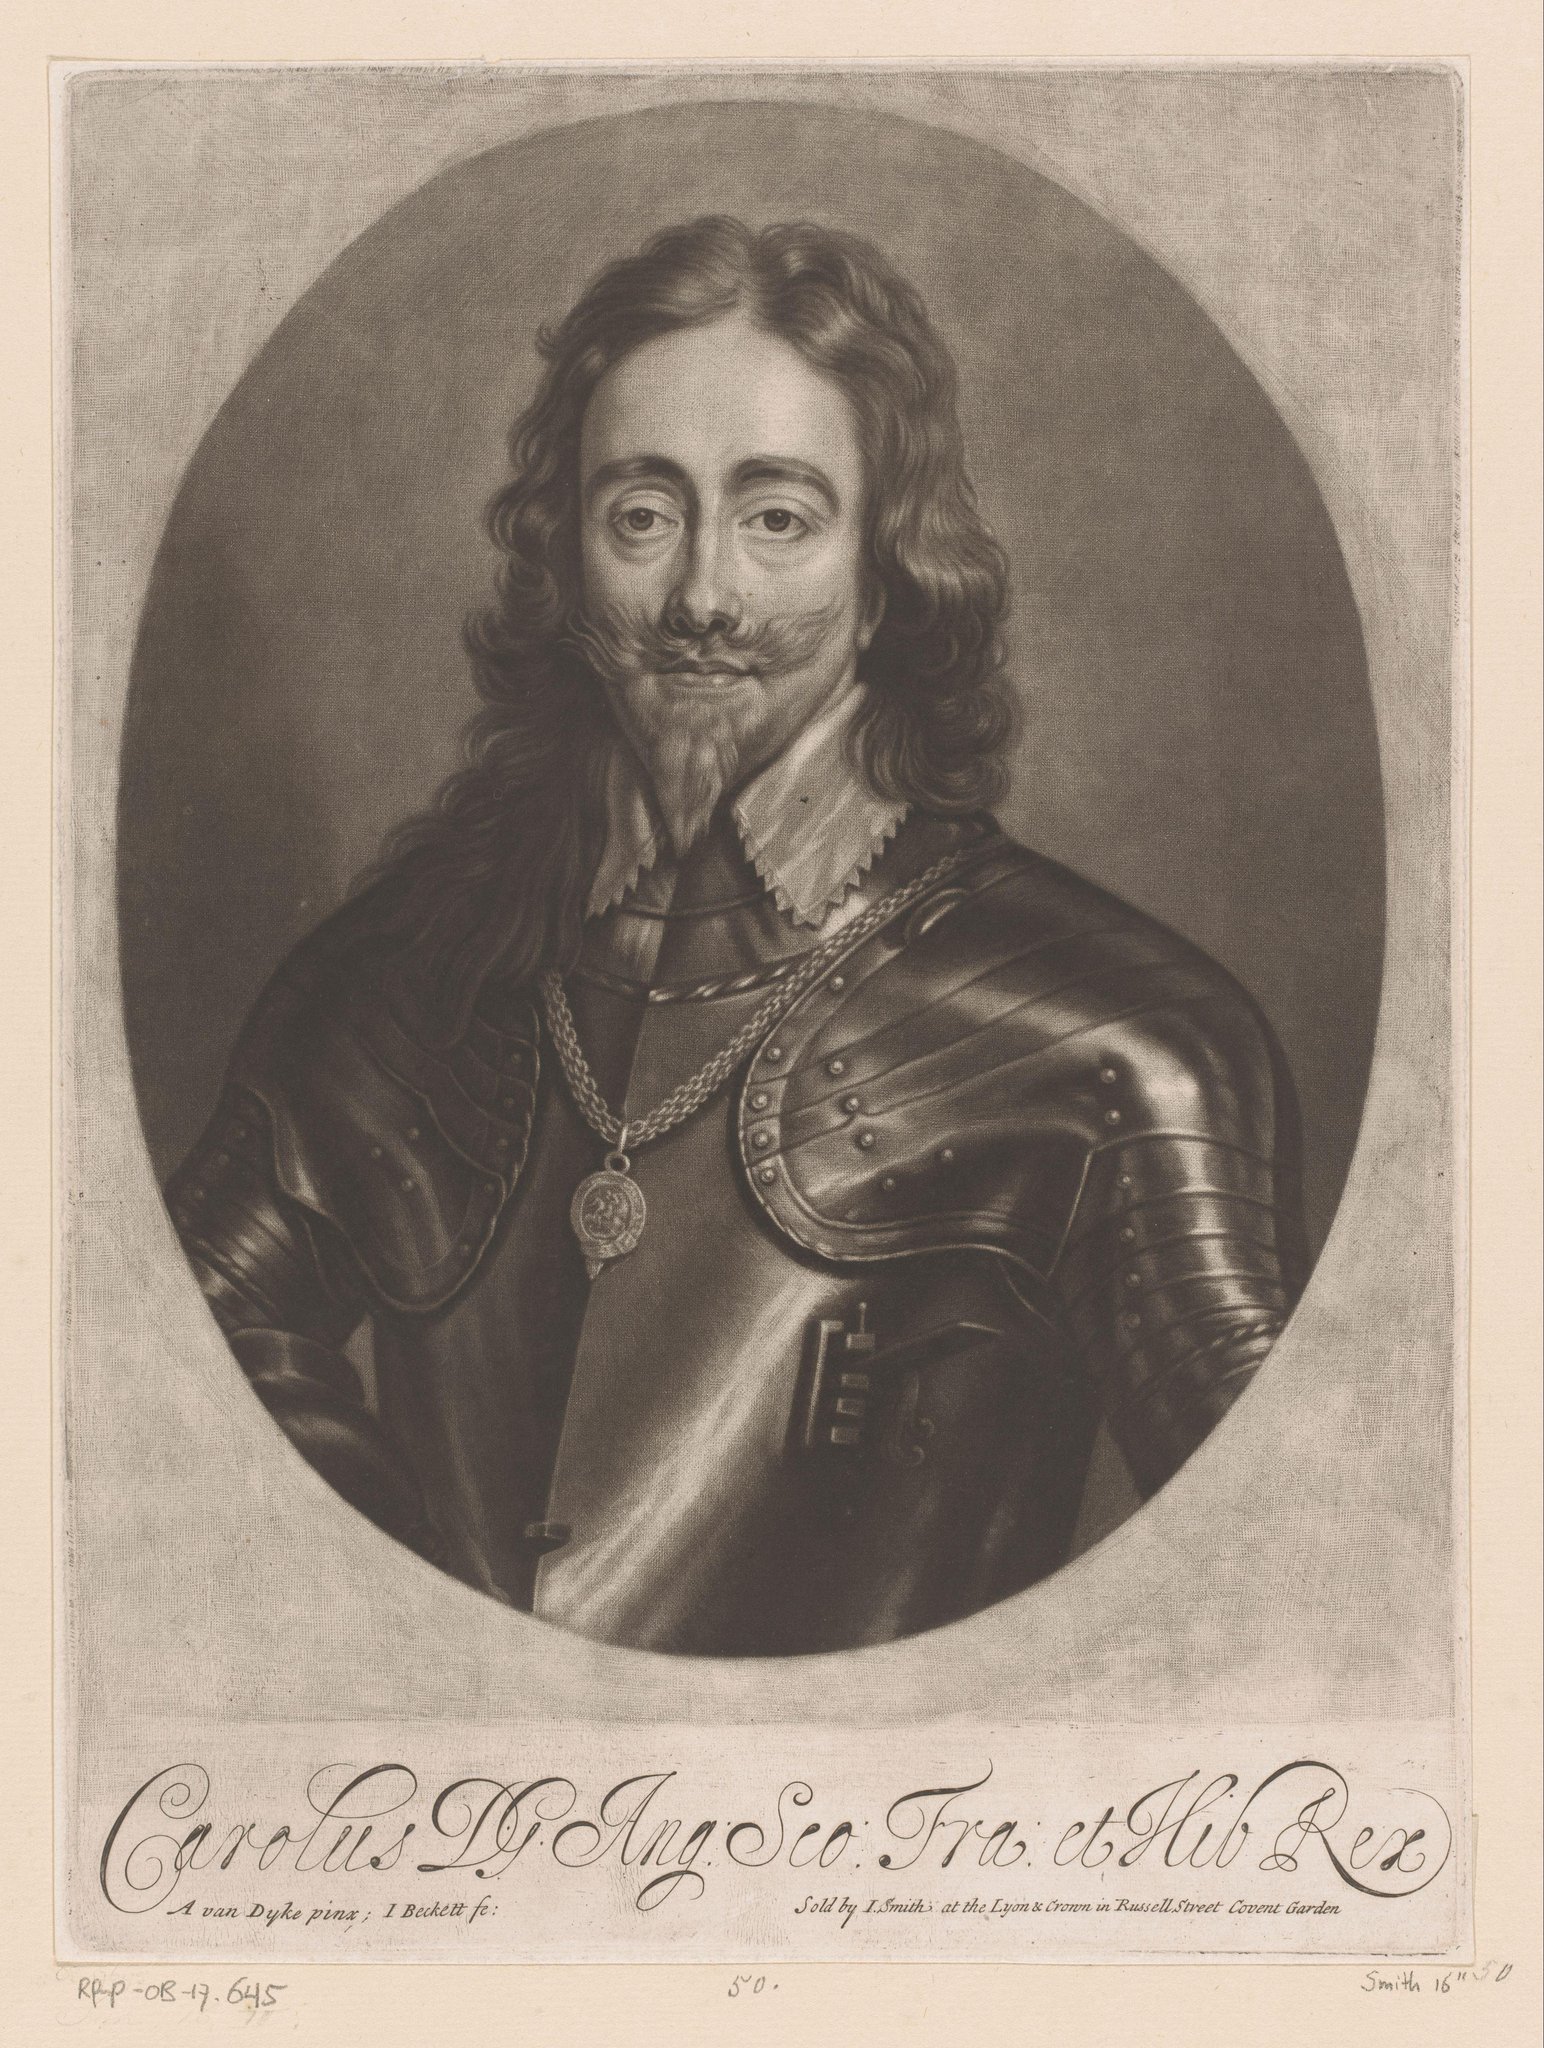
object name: print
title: Carolus D G Ang Sco Fra et Hib Rex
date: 1683-1687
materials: paper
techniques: mezzotint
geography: london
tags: london, karel i (koning van engeland), historical persons, king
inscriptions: collector's mark: Lugt 240